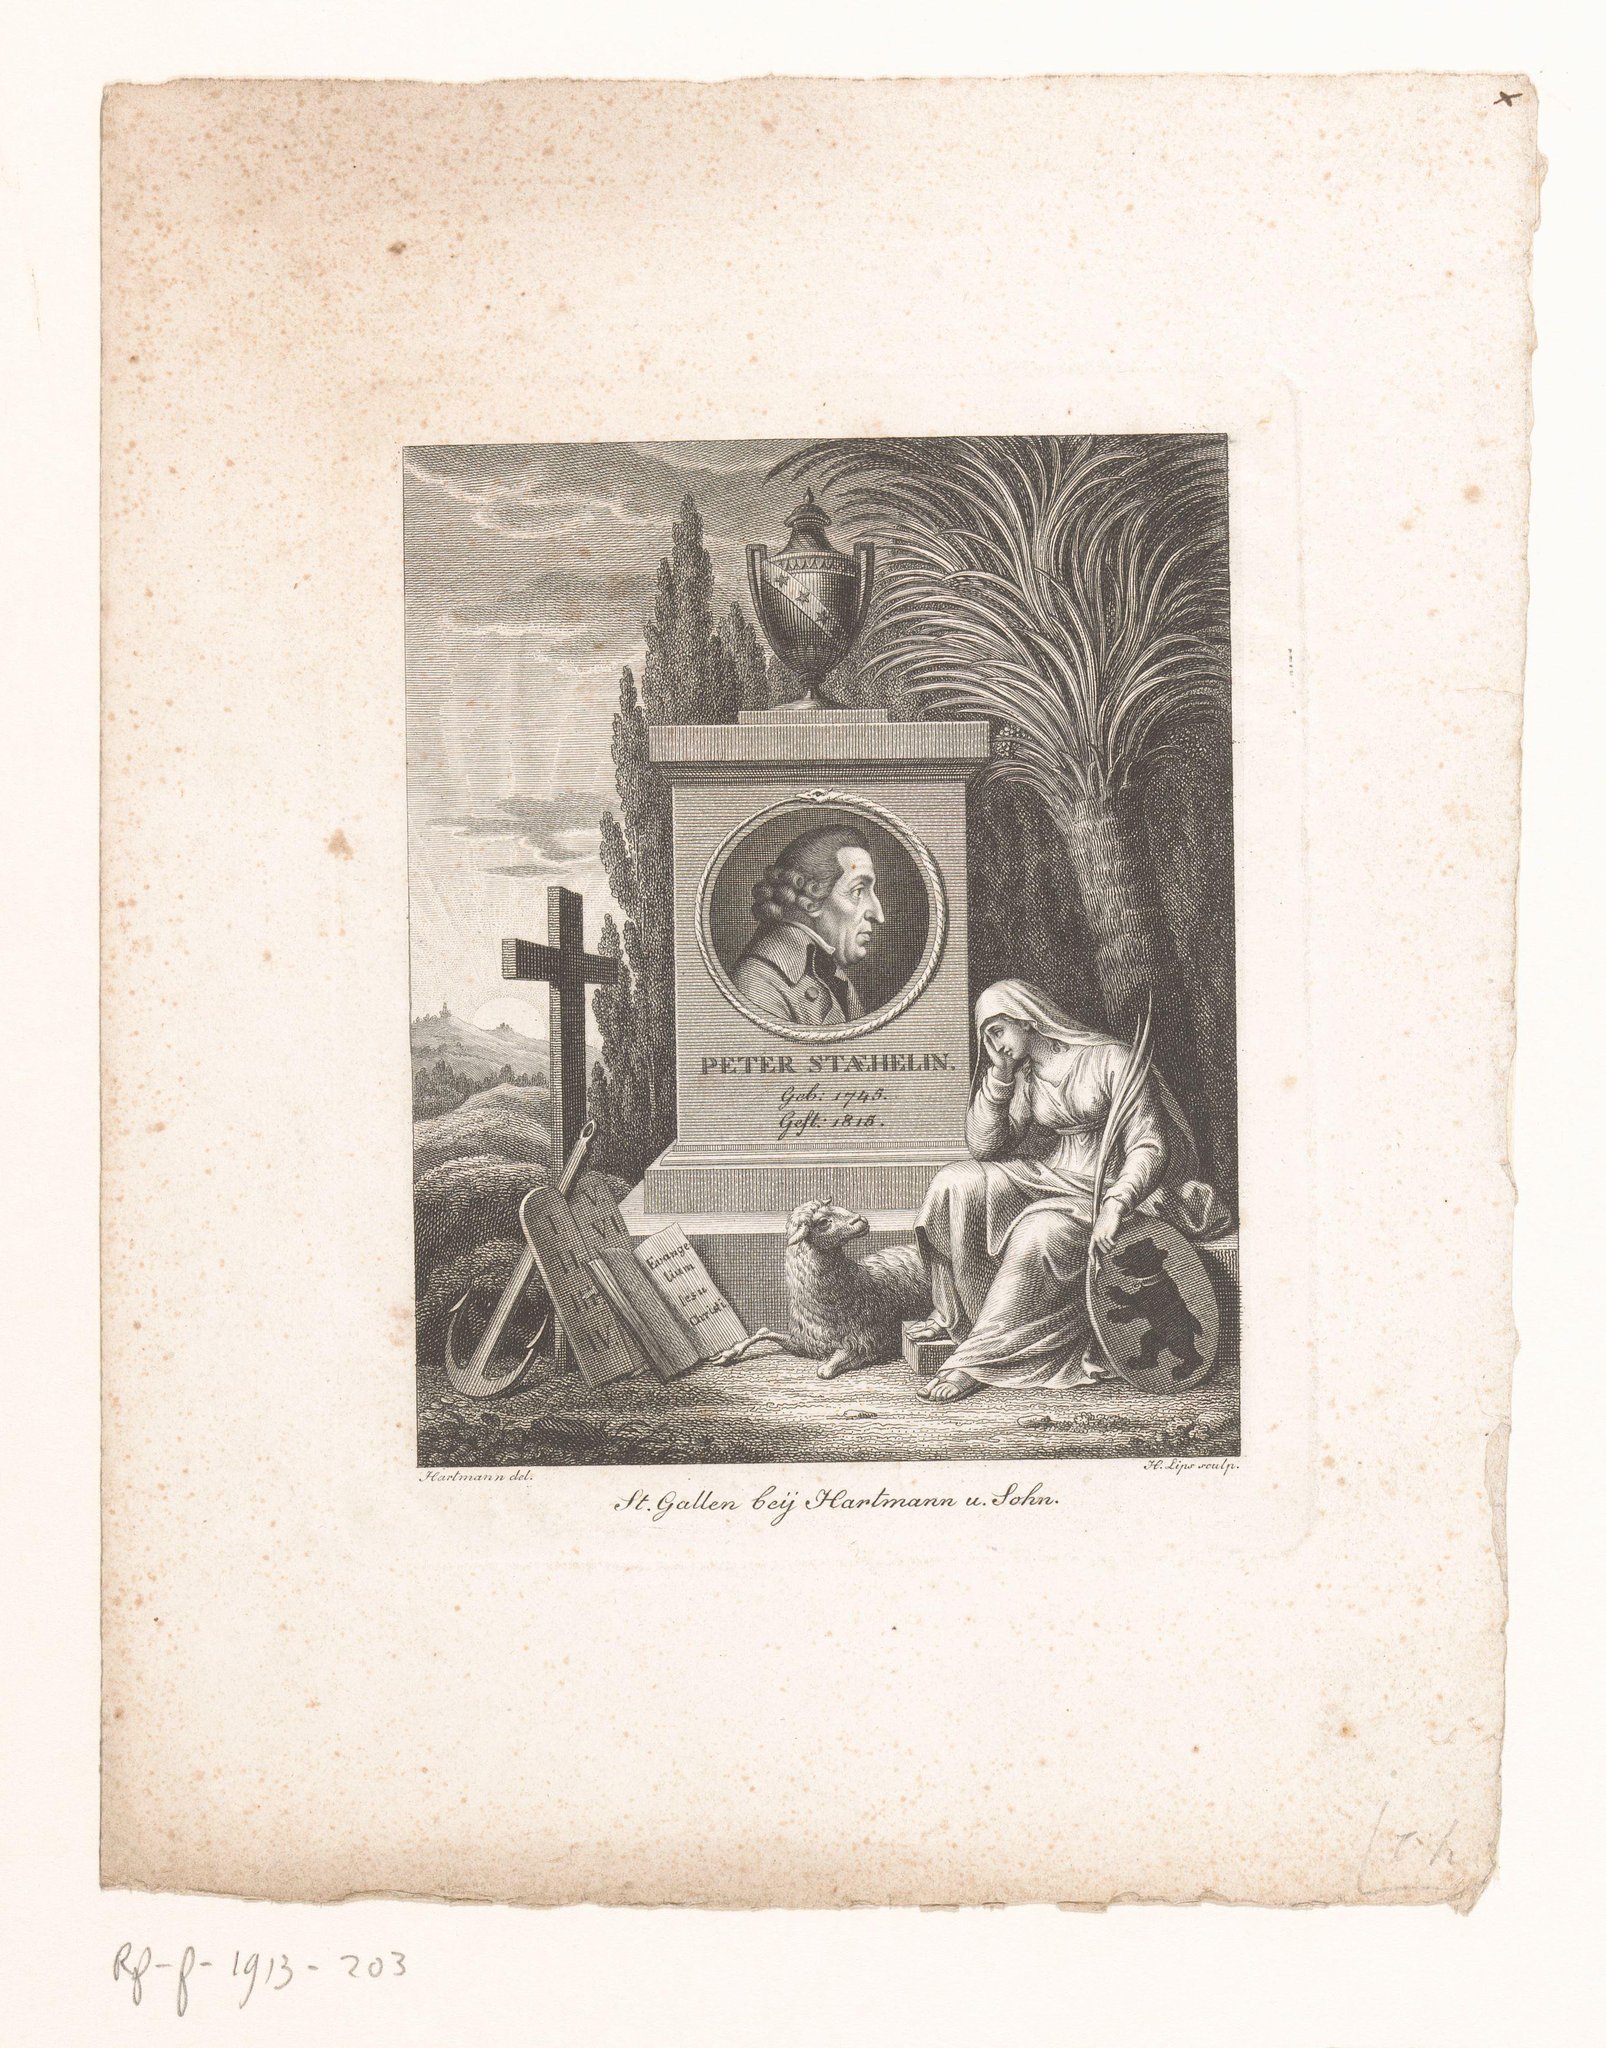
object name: print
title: Grafmonument met portret van Peter Stähelin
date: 1815-1817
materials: paper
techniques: engraving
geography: sankt gallen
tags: historical persons, grave-building, monumental tomb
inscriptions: collector's mark: Lugt 2228